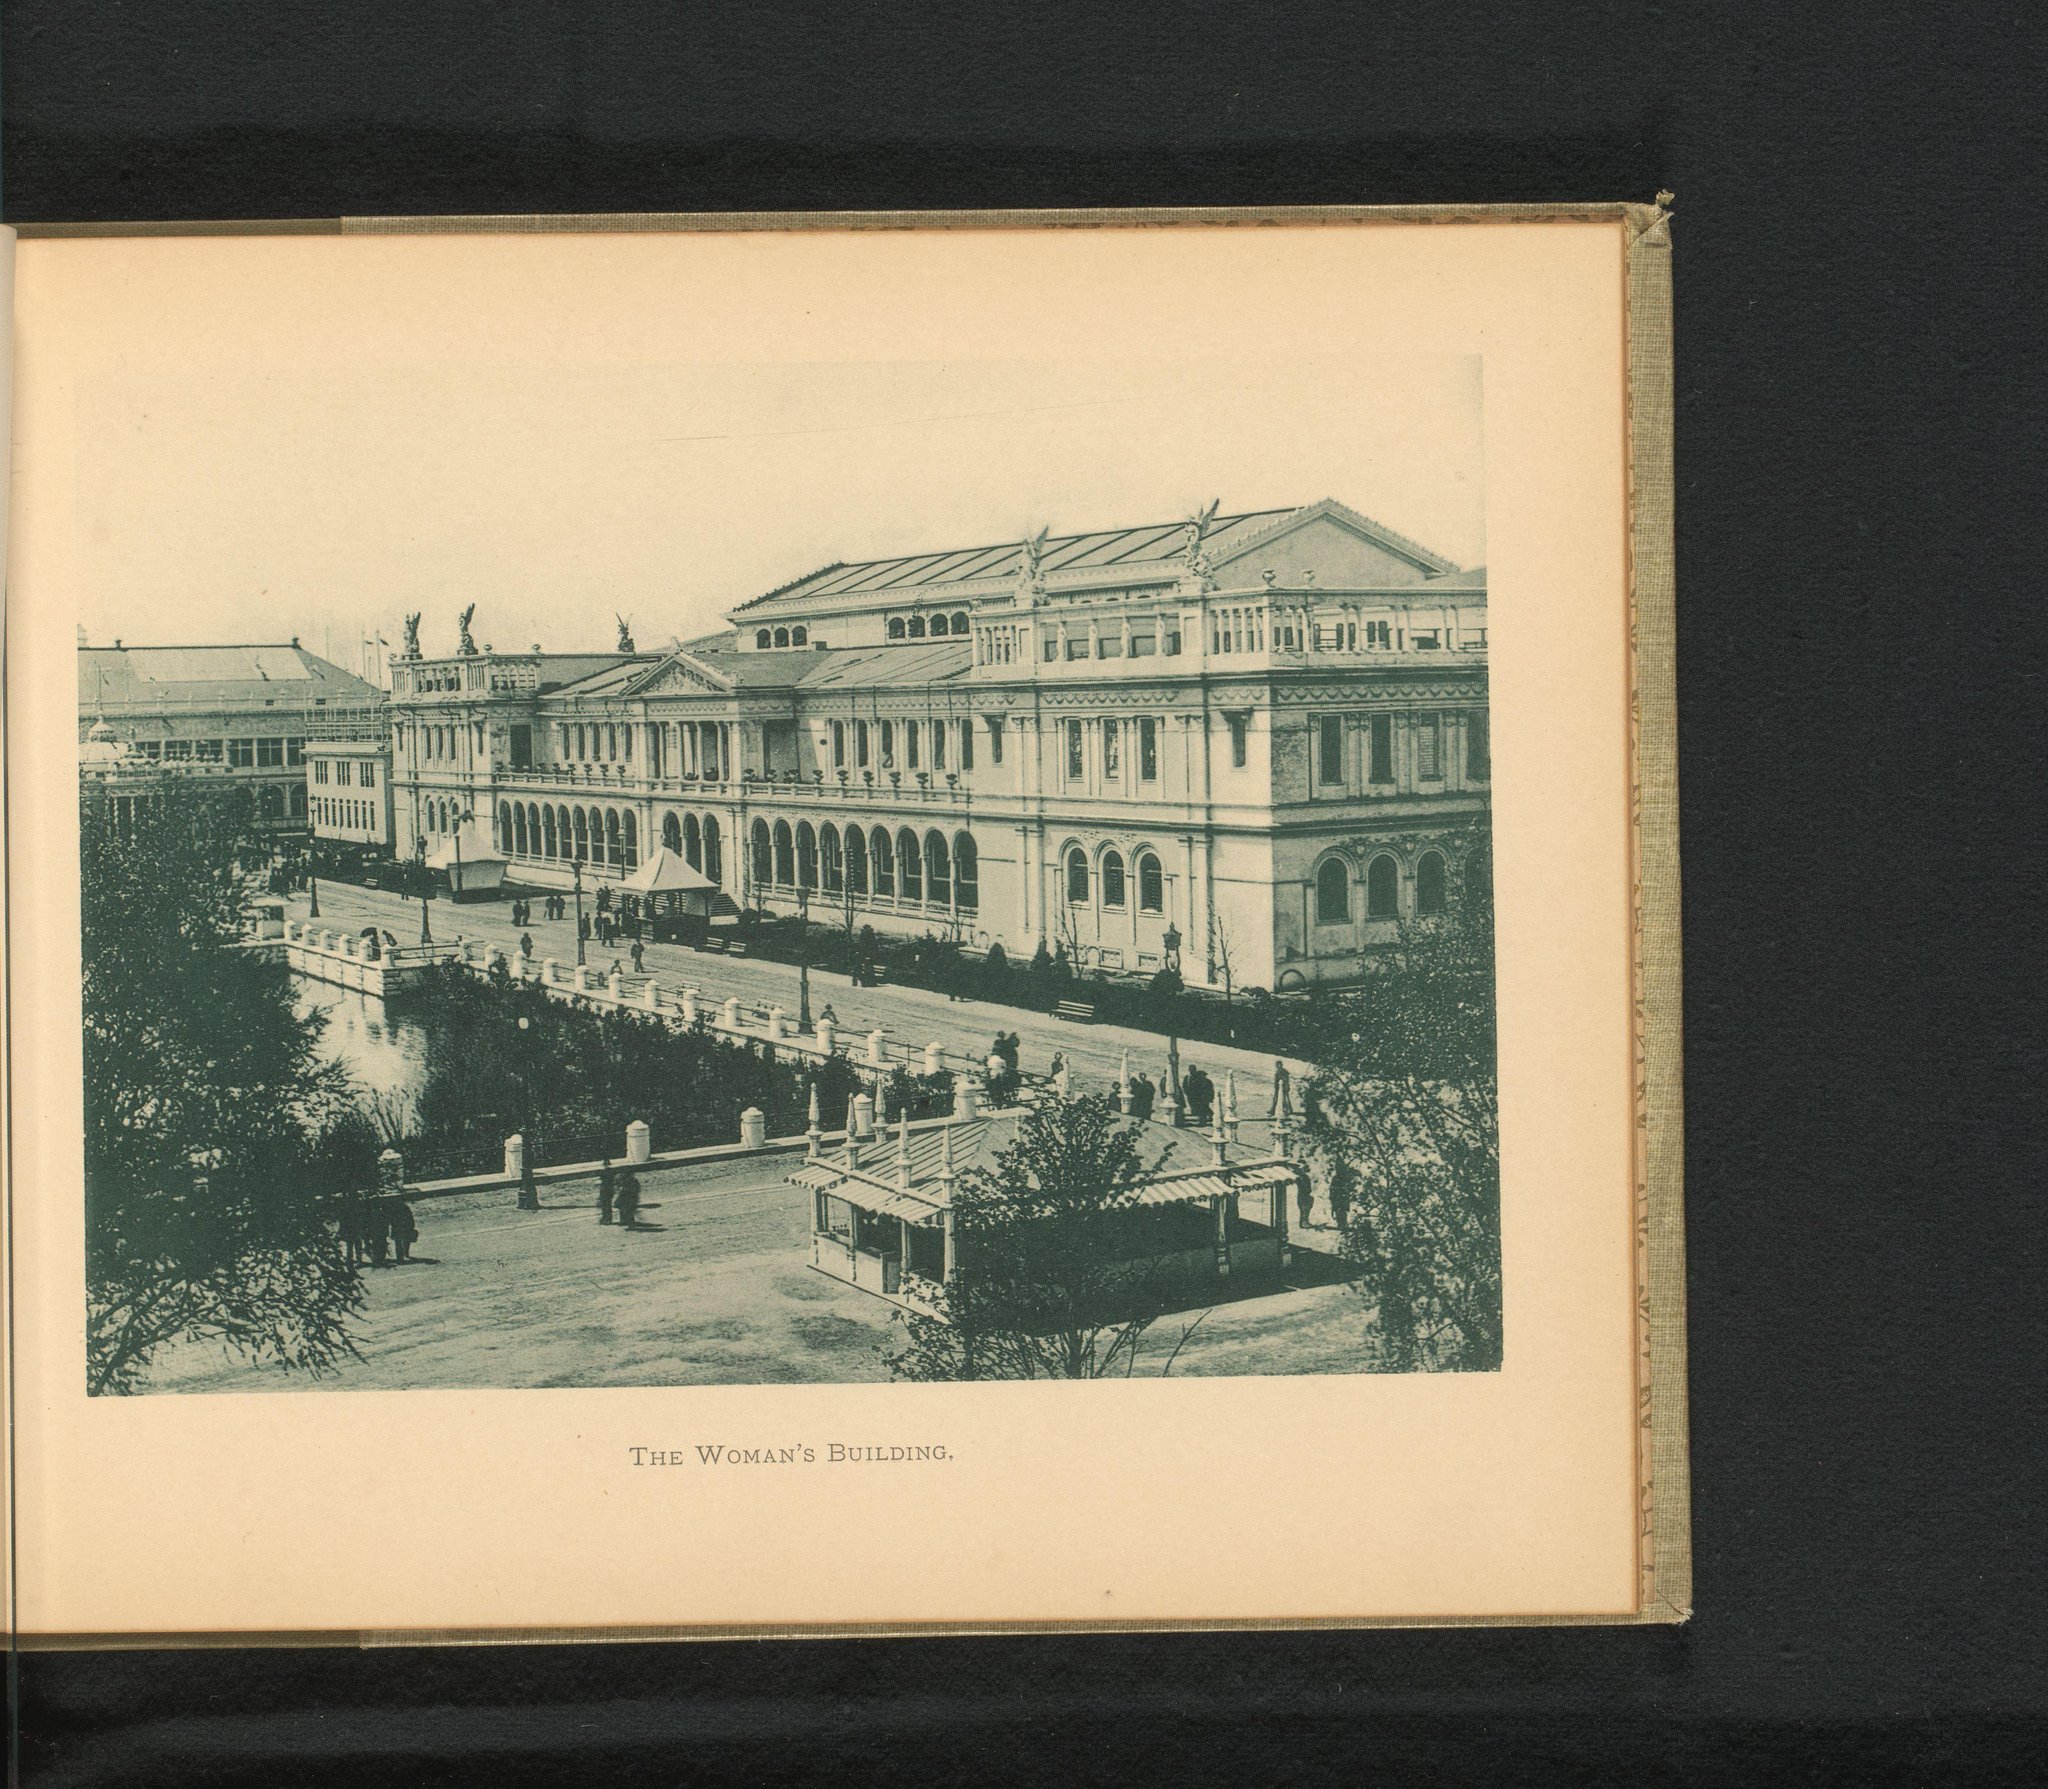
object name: page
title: Gezicht op het vrouwengebouw, ontworpen door Sophia Hayden op de World's Columbian Exposition in Chicago in 1893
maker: Anonymous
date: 1893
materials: paper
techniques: photograph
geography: chicago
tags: world fair, world exhibition